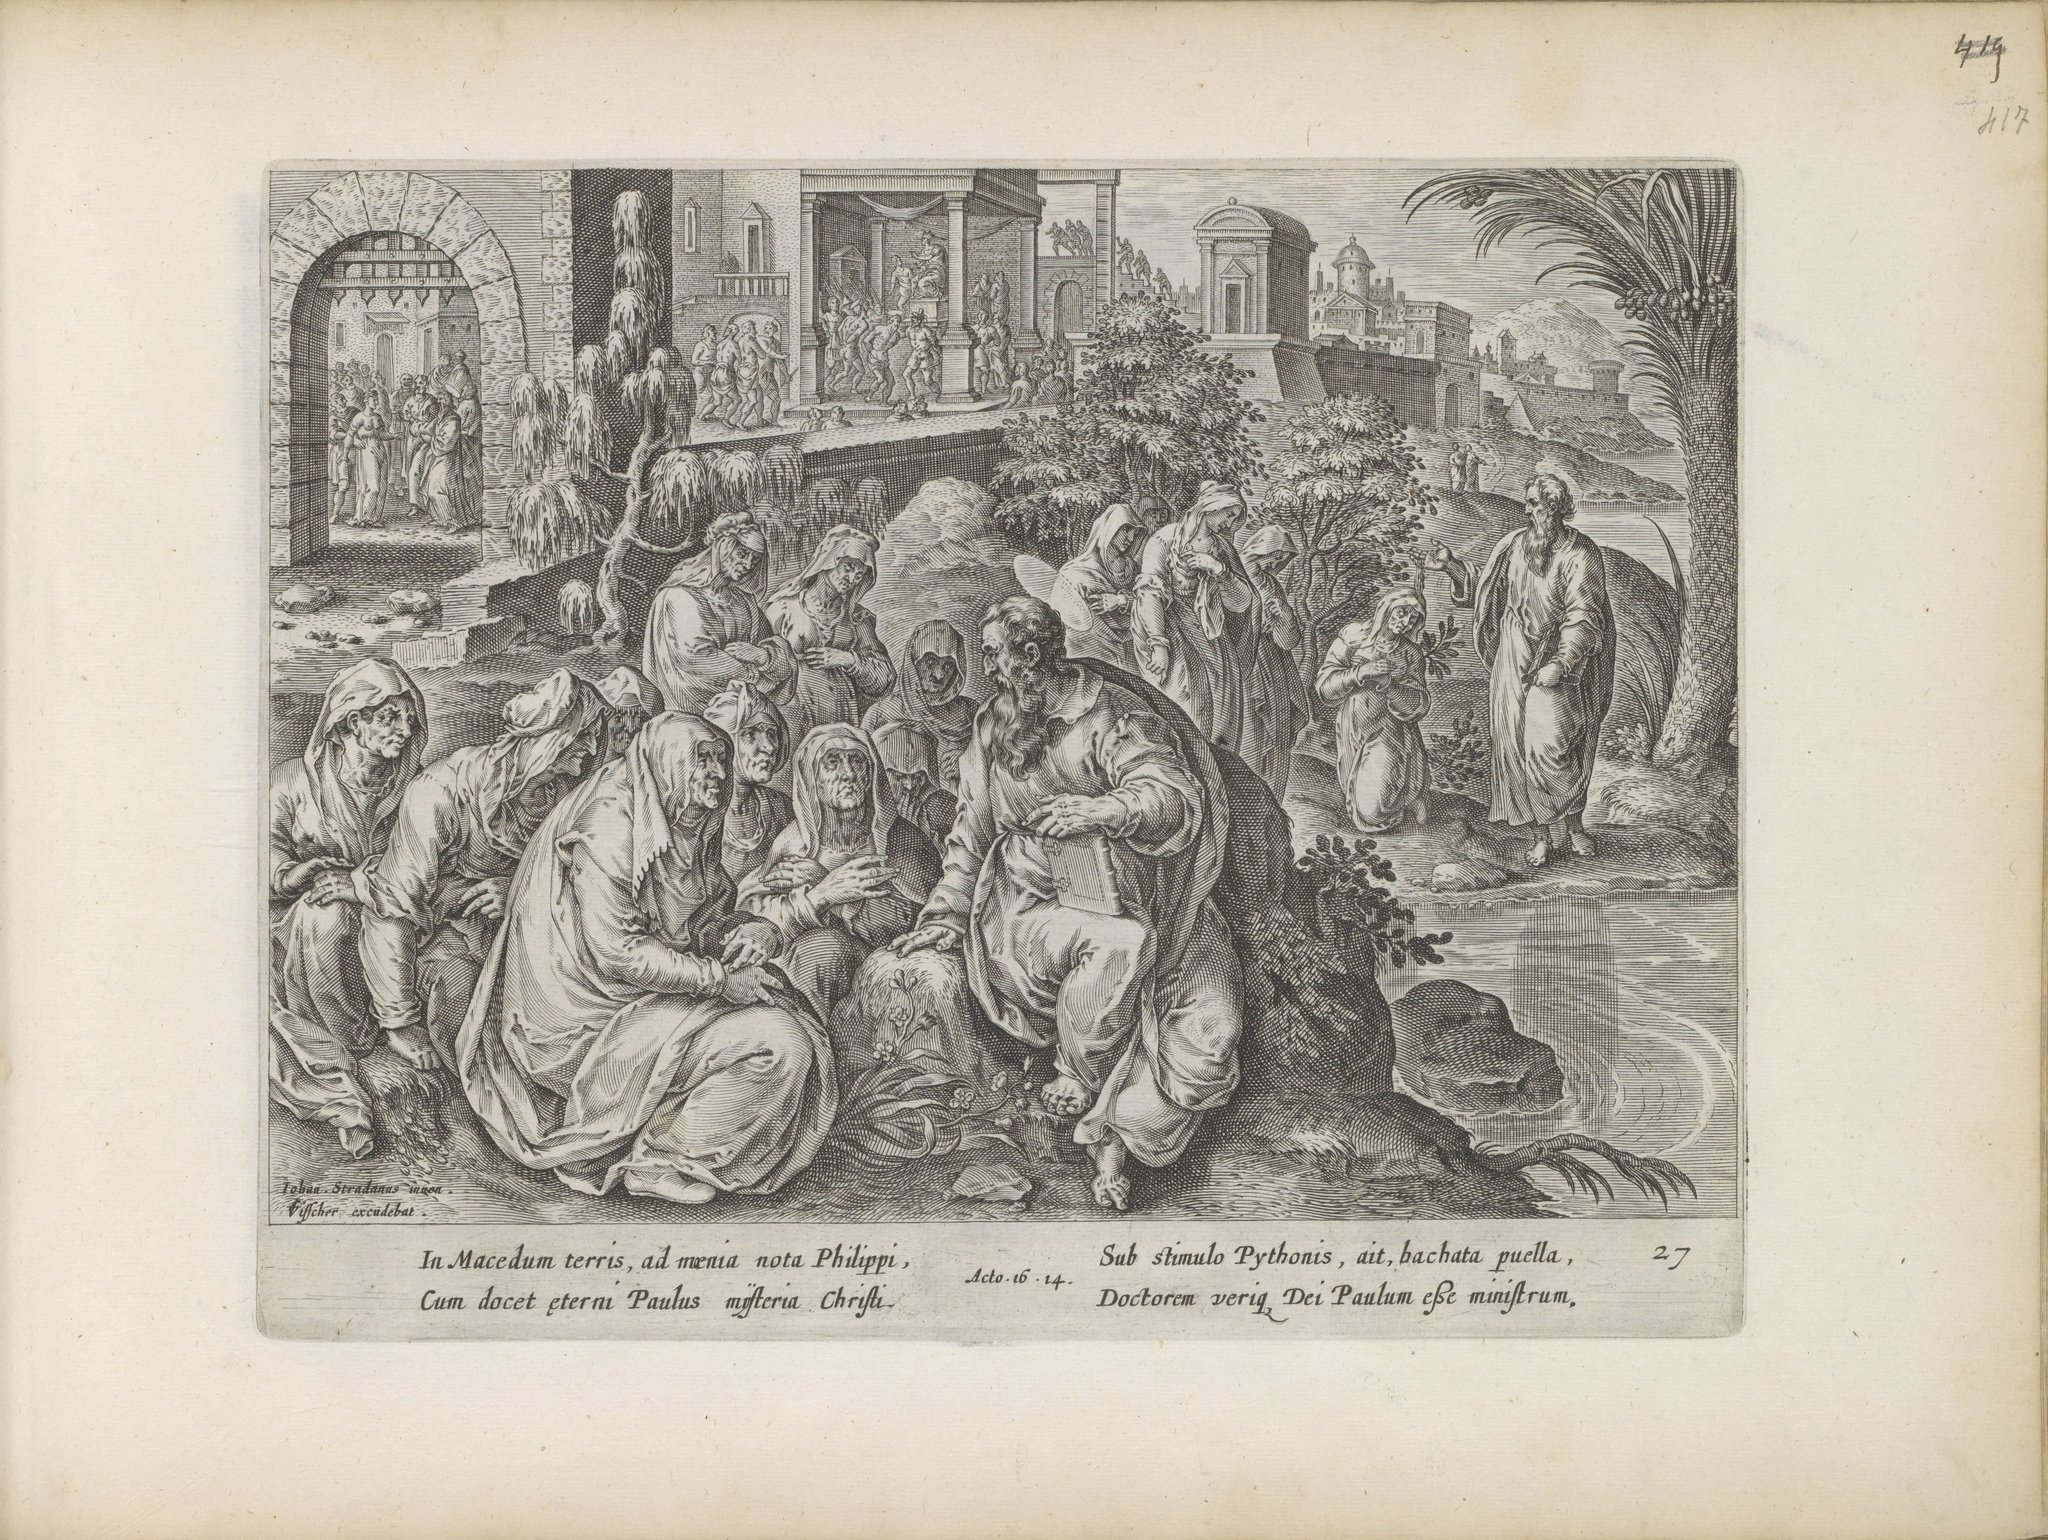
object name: album leaf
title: Theatrum Biblicum Hoc Est Historiae Sacrae Veteris et Novi Testamenti Tabulis Aeneis Expressae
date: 1643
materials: paper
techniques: engraving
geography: amsterdam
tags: the conversion and baptism of lydia, a seller of purple, paul and silas brought before the magistrates by the masters of the healed woman servant, the healing of the woman servant with a divining spirit ~ paul and silas at philippi, near a river paul and silas preach to the women of philippi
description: Aan de oever van een rivier spreekt de apostel Paulus de vrouwen van de stad Filippi toe, die daar bijeen zijn gekomen om te bidden. Een van de vrouwen, Lydia, laat zich (rechtsachter) samen met haar huisgenoten dopen. Links op de achtergrond verdrijft Paulus een geest uit een vrouw. Paulus en Silas worden vervolgens gearresteerd en krijgen stokslagen voor het verstoren van de orde. Onder de voorstelling een verwijzing in het Latijn naar de Bijbeltekst in Hand. 16:14. Deze prent maakt deel uit van een album.